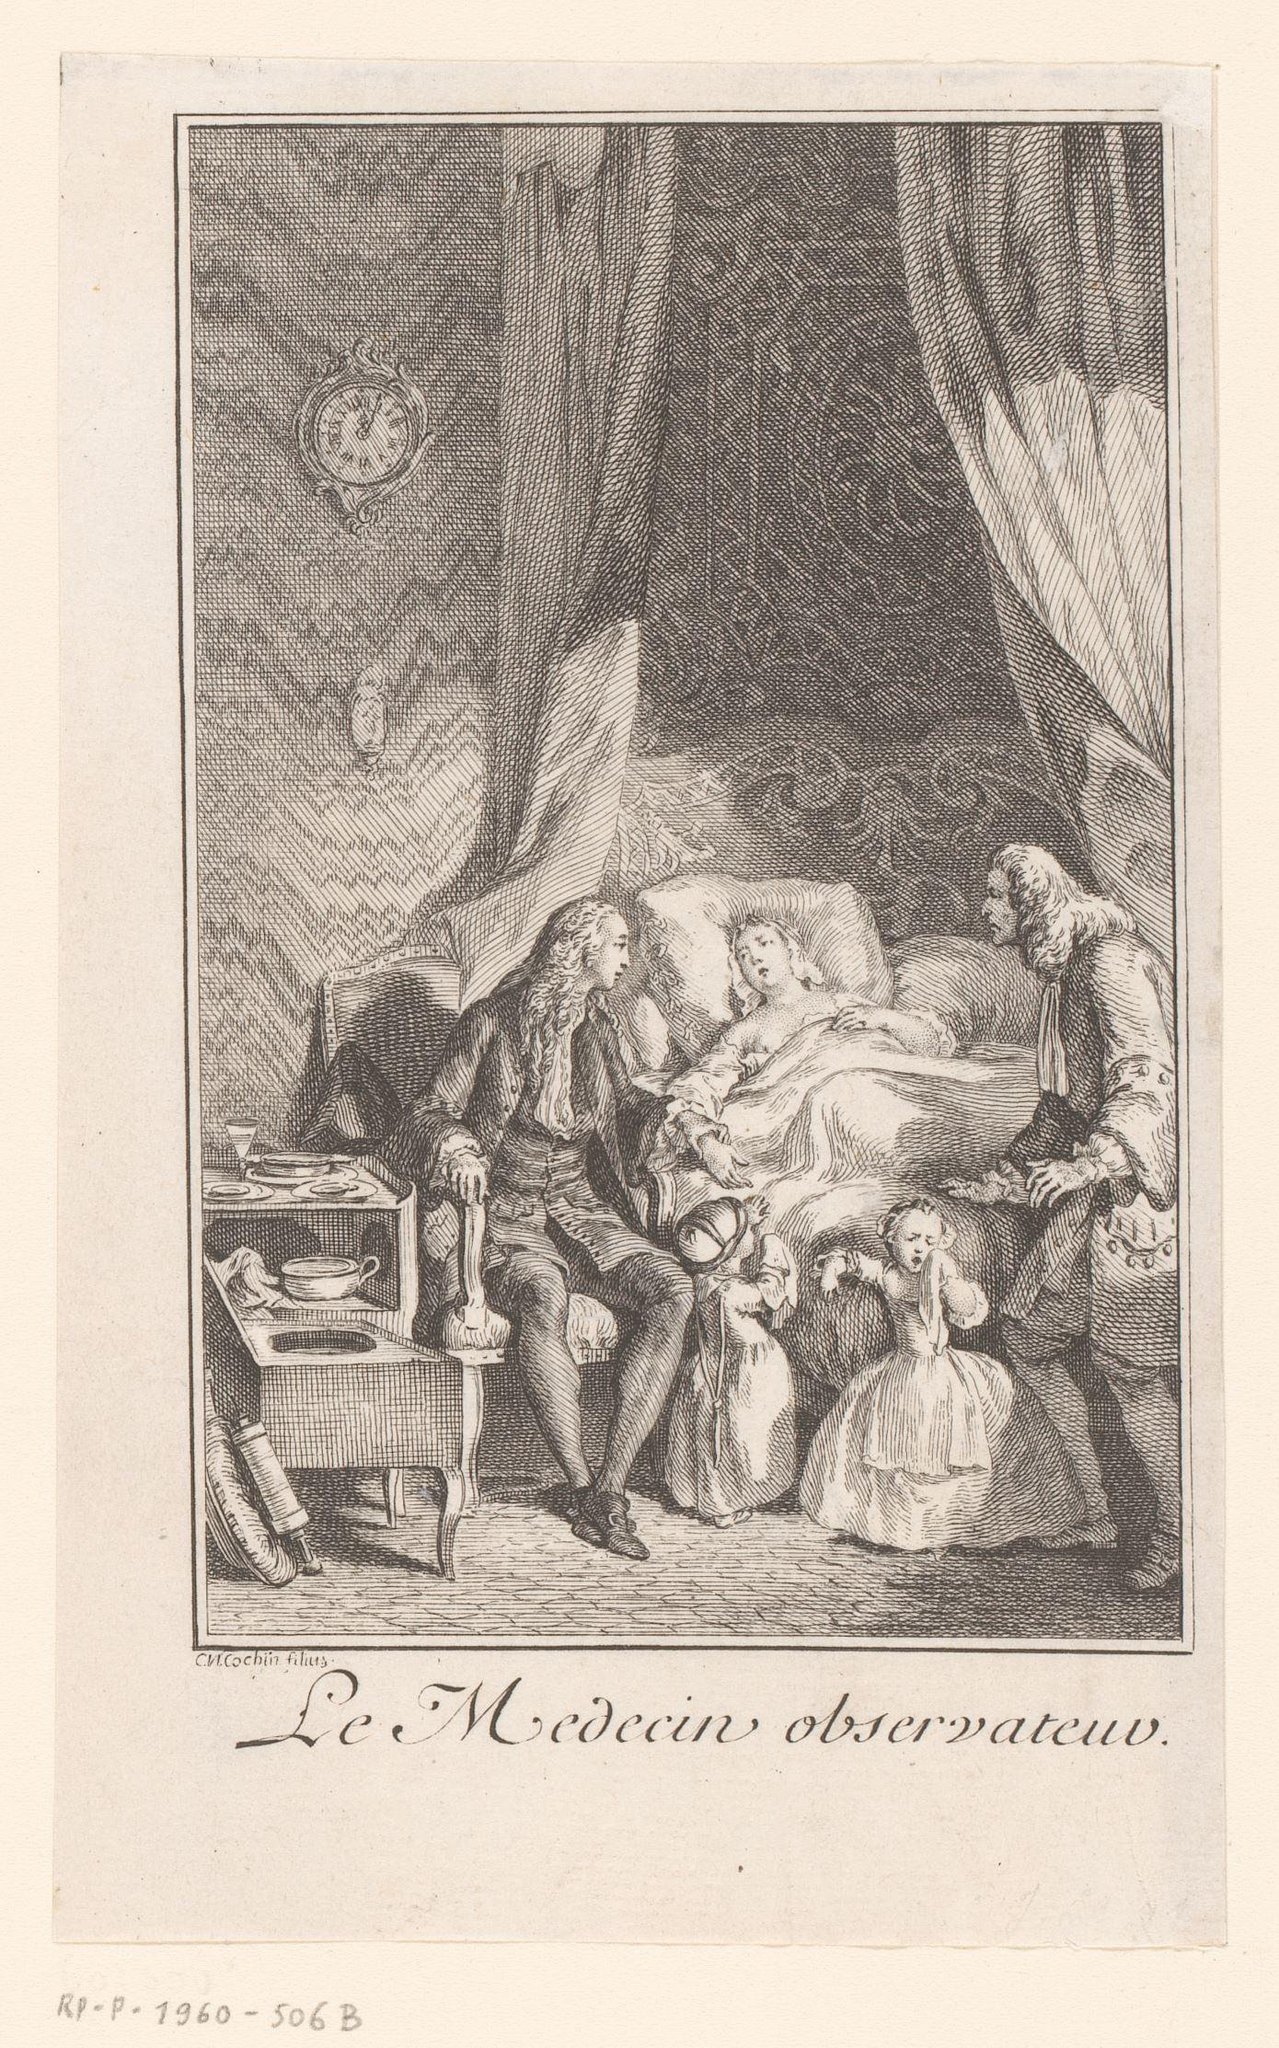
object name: print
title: Vrouw op haar ziekbed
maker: charles nicolas cochin (ii)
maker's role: draughtsman, print maker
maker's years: 1715-1790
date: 1742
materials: paper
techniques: engraving, etching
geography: france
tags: sick-bed, physician, doctor, weeping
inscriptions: collector's mark: Lugt 2228